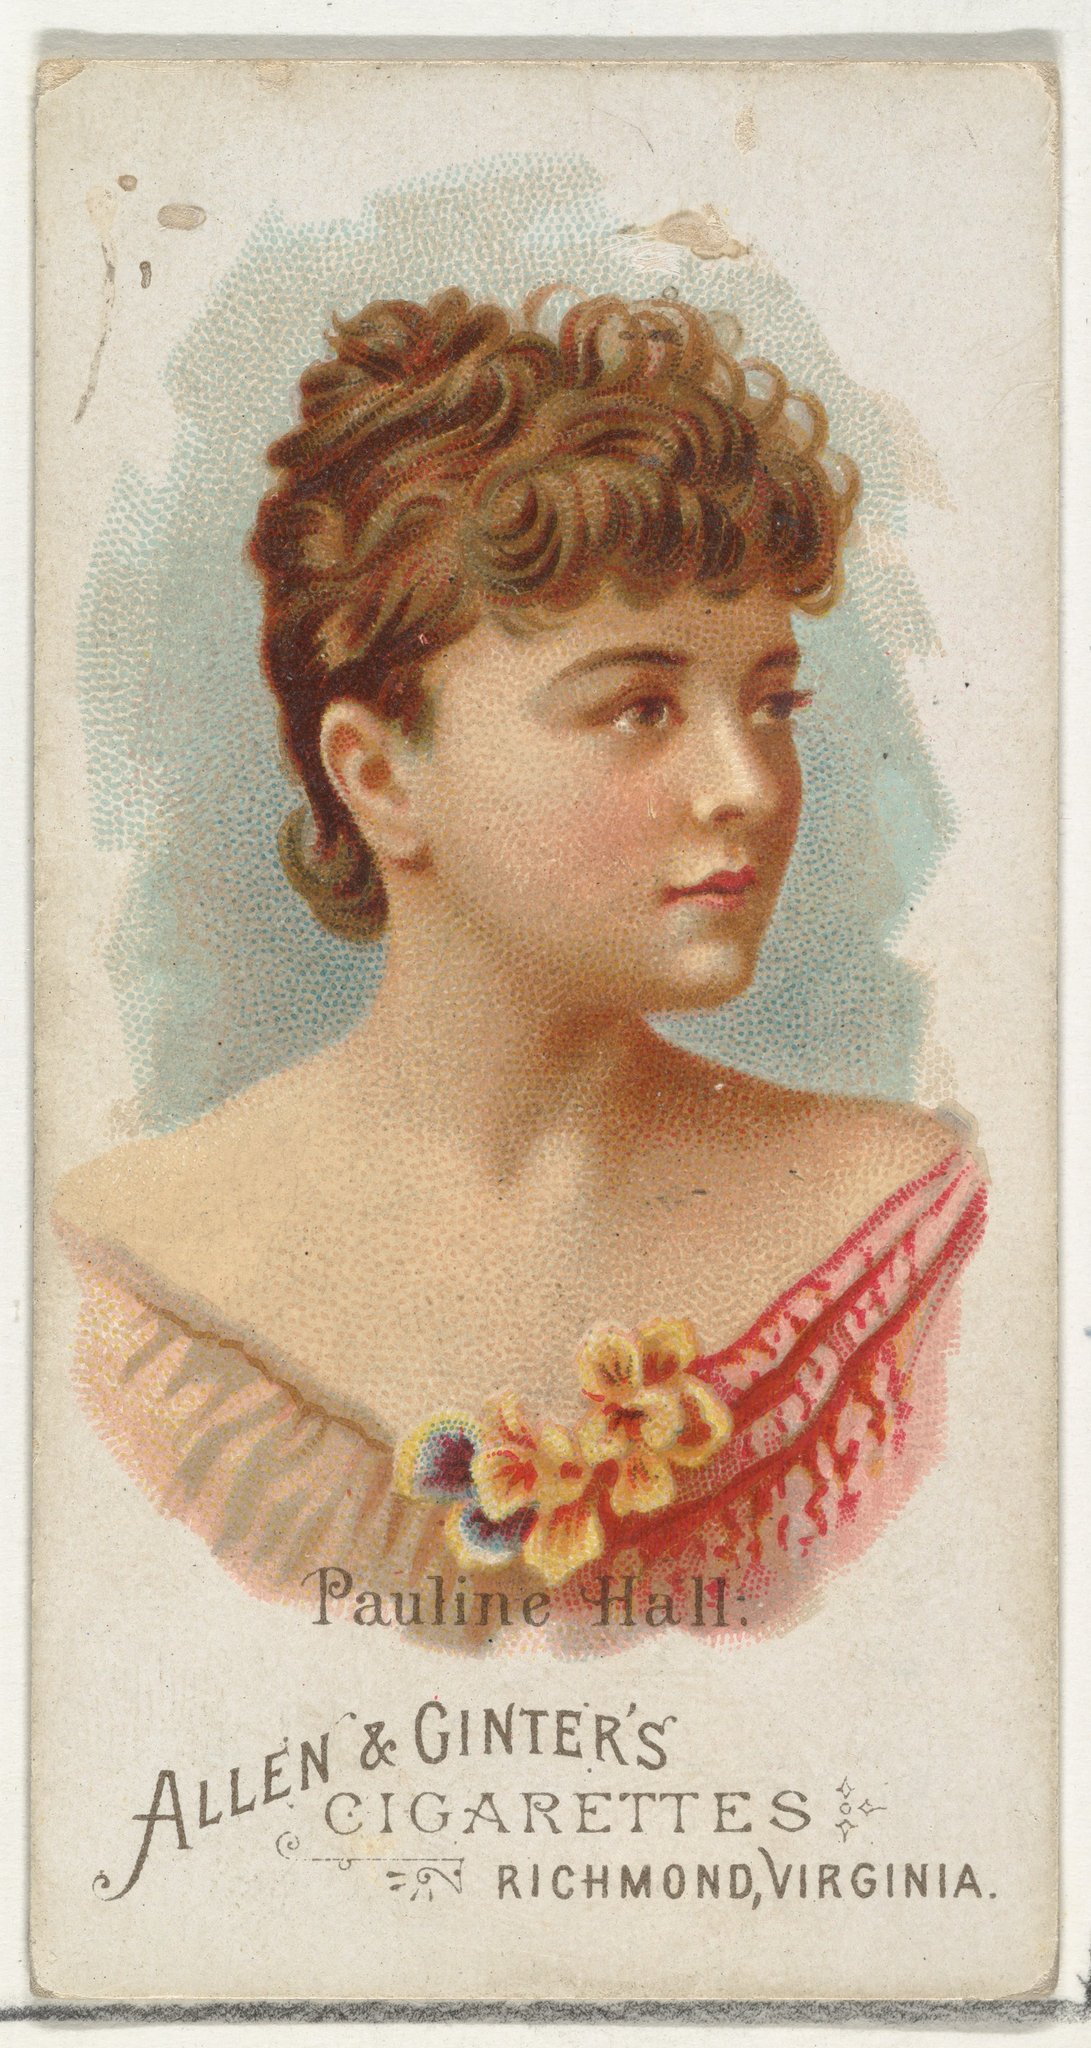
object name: print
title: Pauline Hall, from World's Beauties, Series 1 (N26) for Allen & Ginter Cigarettes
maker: allen & ginter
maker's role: publisher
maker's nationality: american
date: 1888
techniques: color lithograph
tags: women